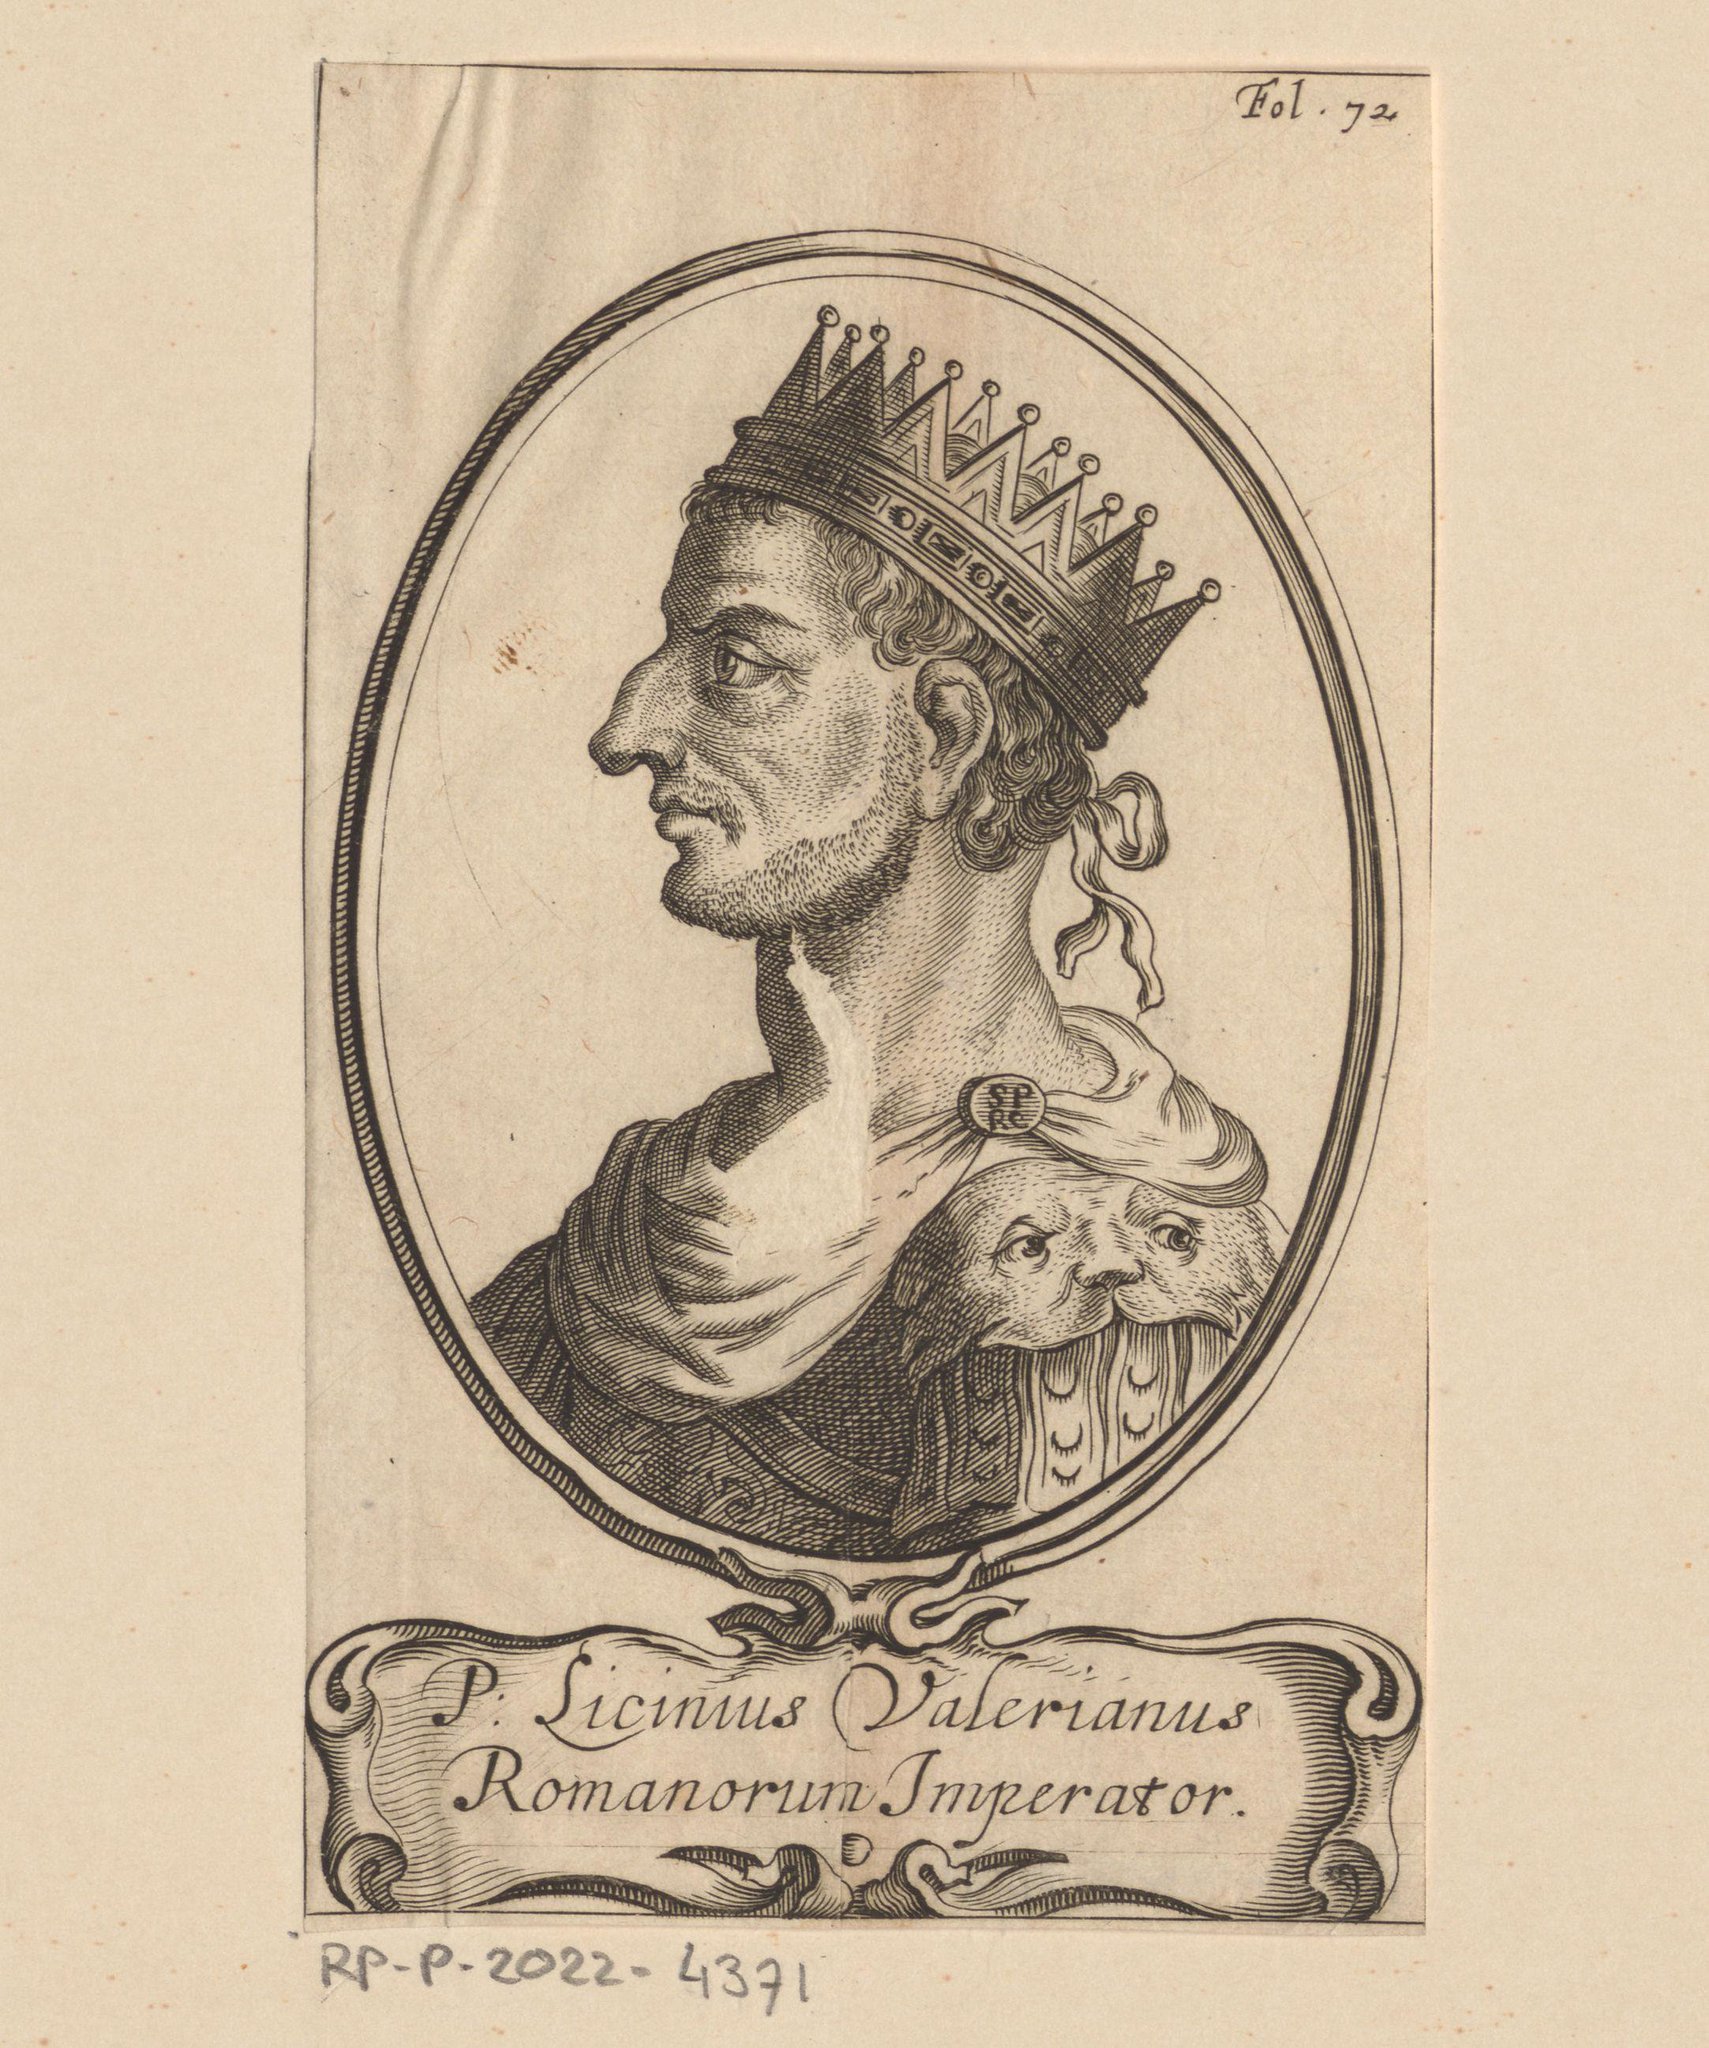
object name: print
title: Portret van keizer Valerianus I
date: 1656-1659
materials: paper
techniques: engraving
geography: northern netherlands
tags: historical persons, emperor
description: Prent gebruikt in: Bos, Lambert van den. Het konincklyk treur-toonneel, ofte op- en ondergangh der keyseren, koningen en vorsten (...). Dordrecht: Jacobus Savry, 1656. Prent ook gebruikt in de 1659-editie.